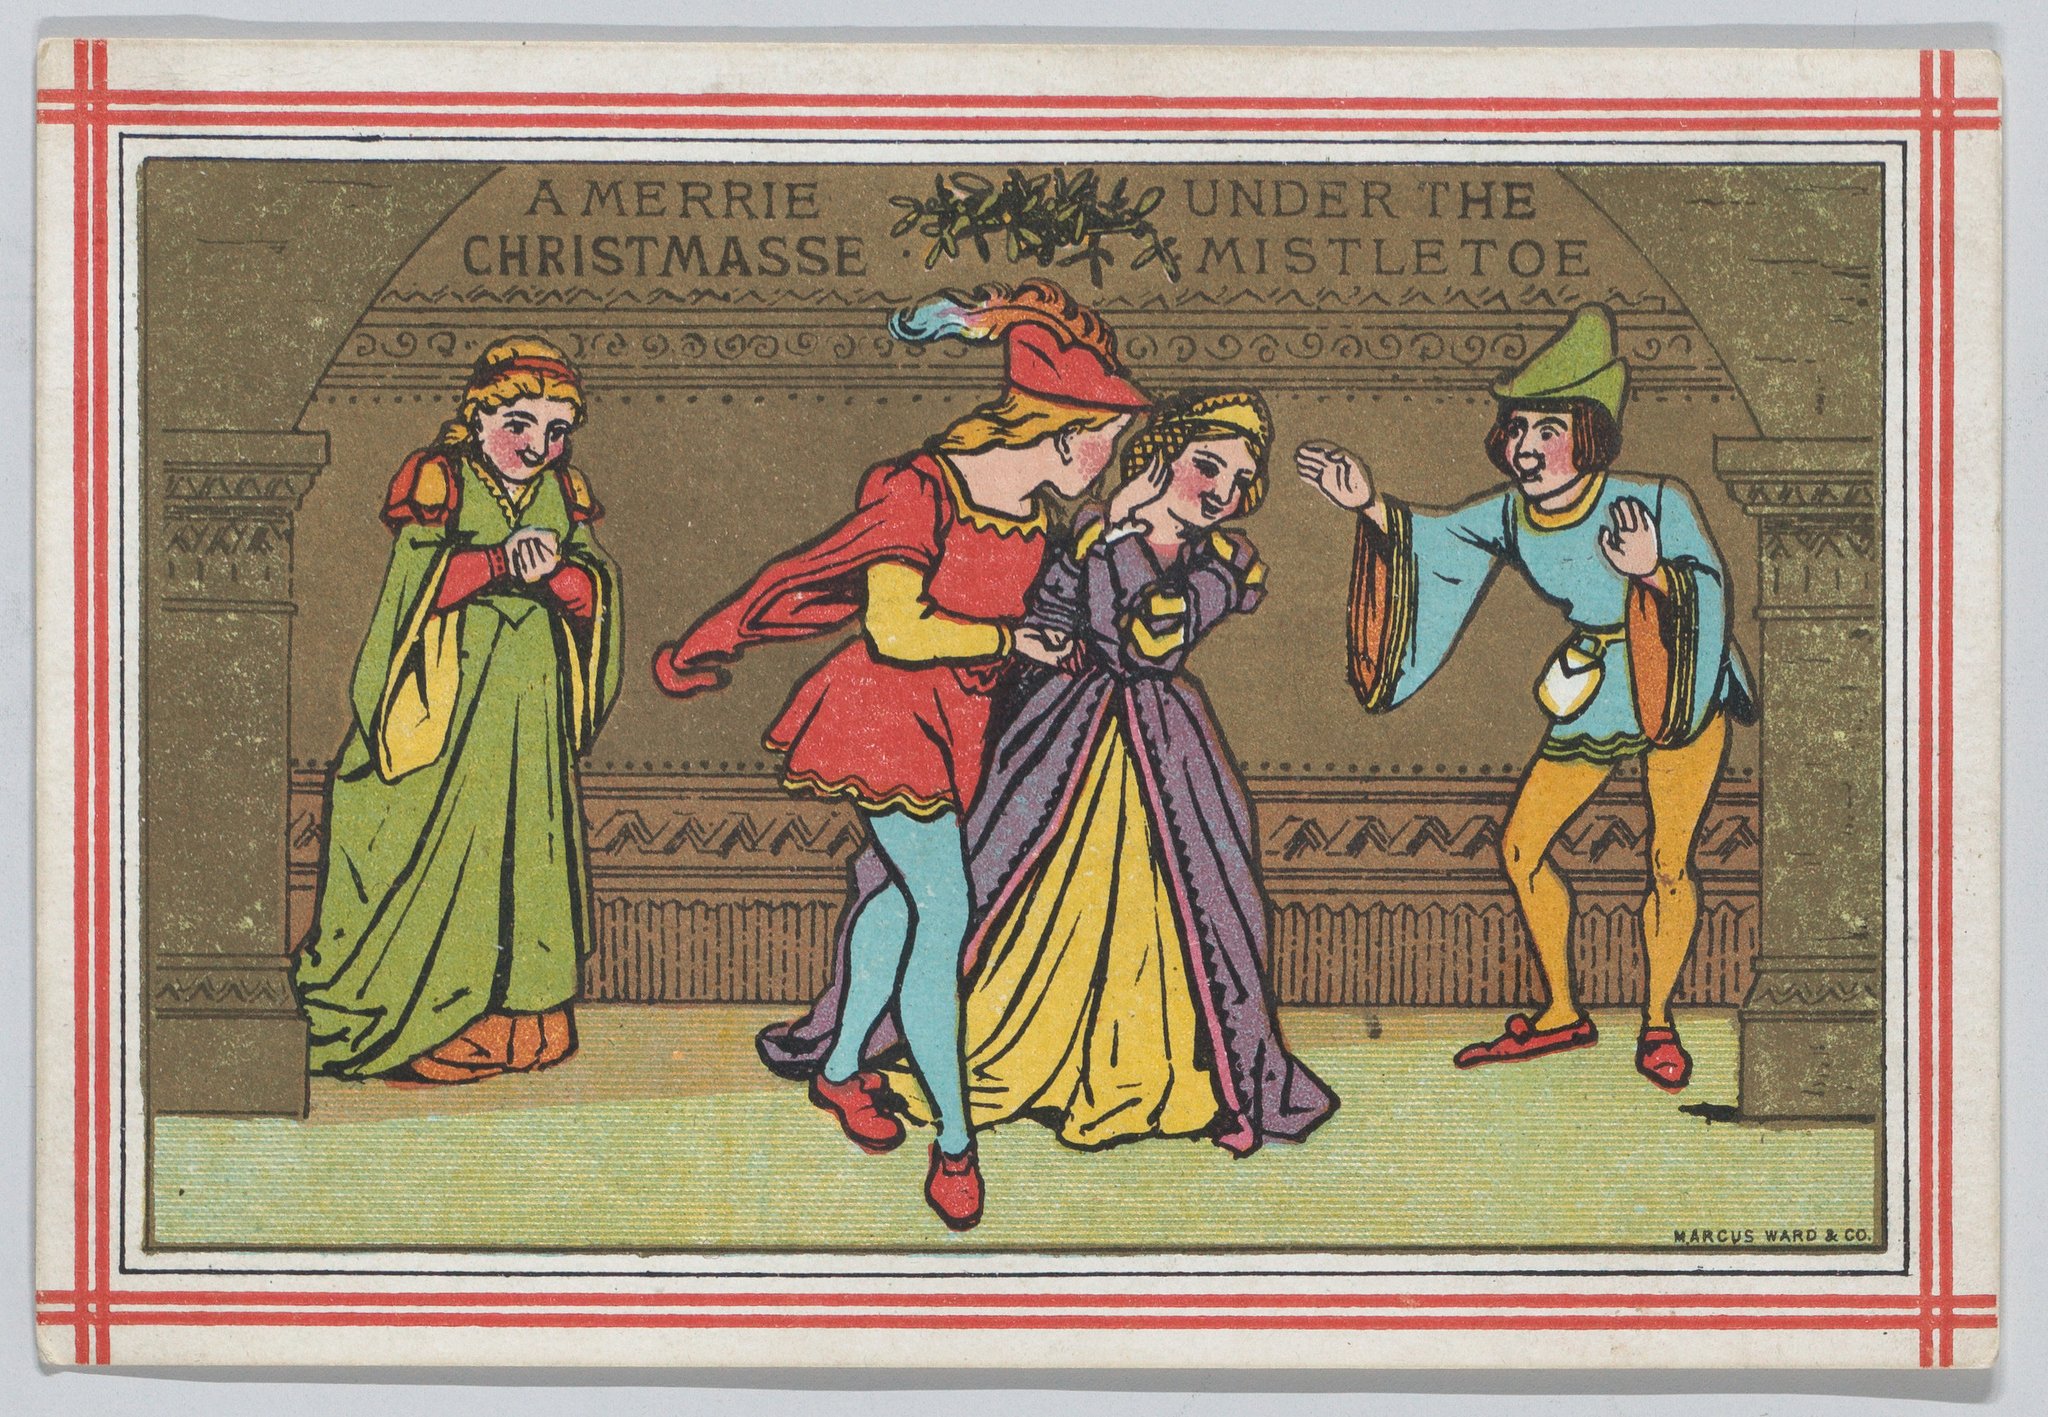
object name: valentine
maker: Anonymous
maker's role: artist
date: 1880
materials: gold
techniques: chromolithography, lithograph